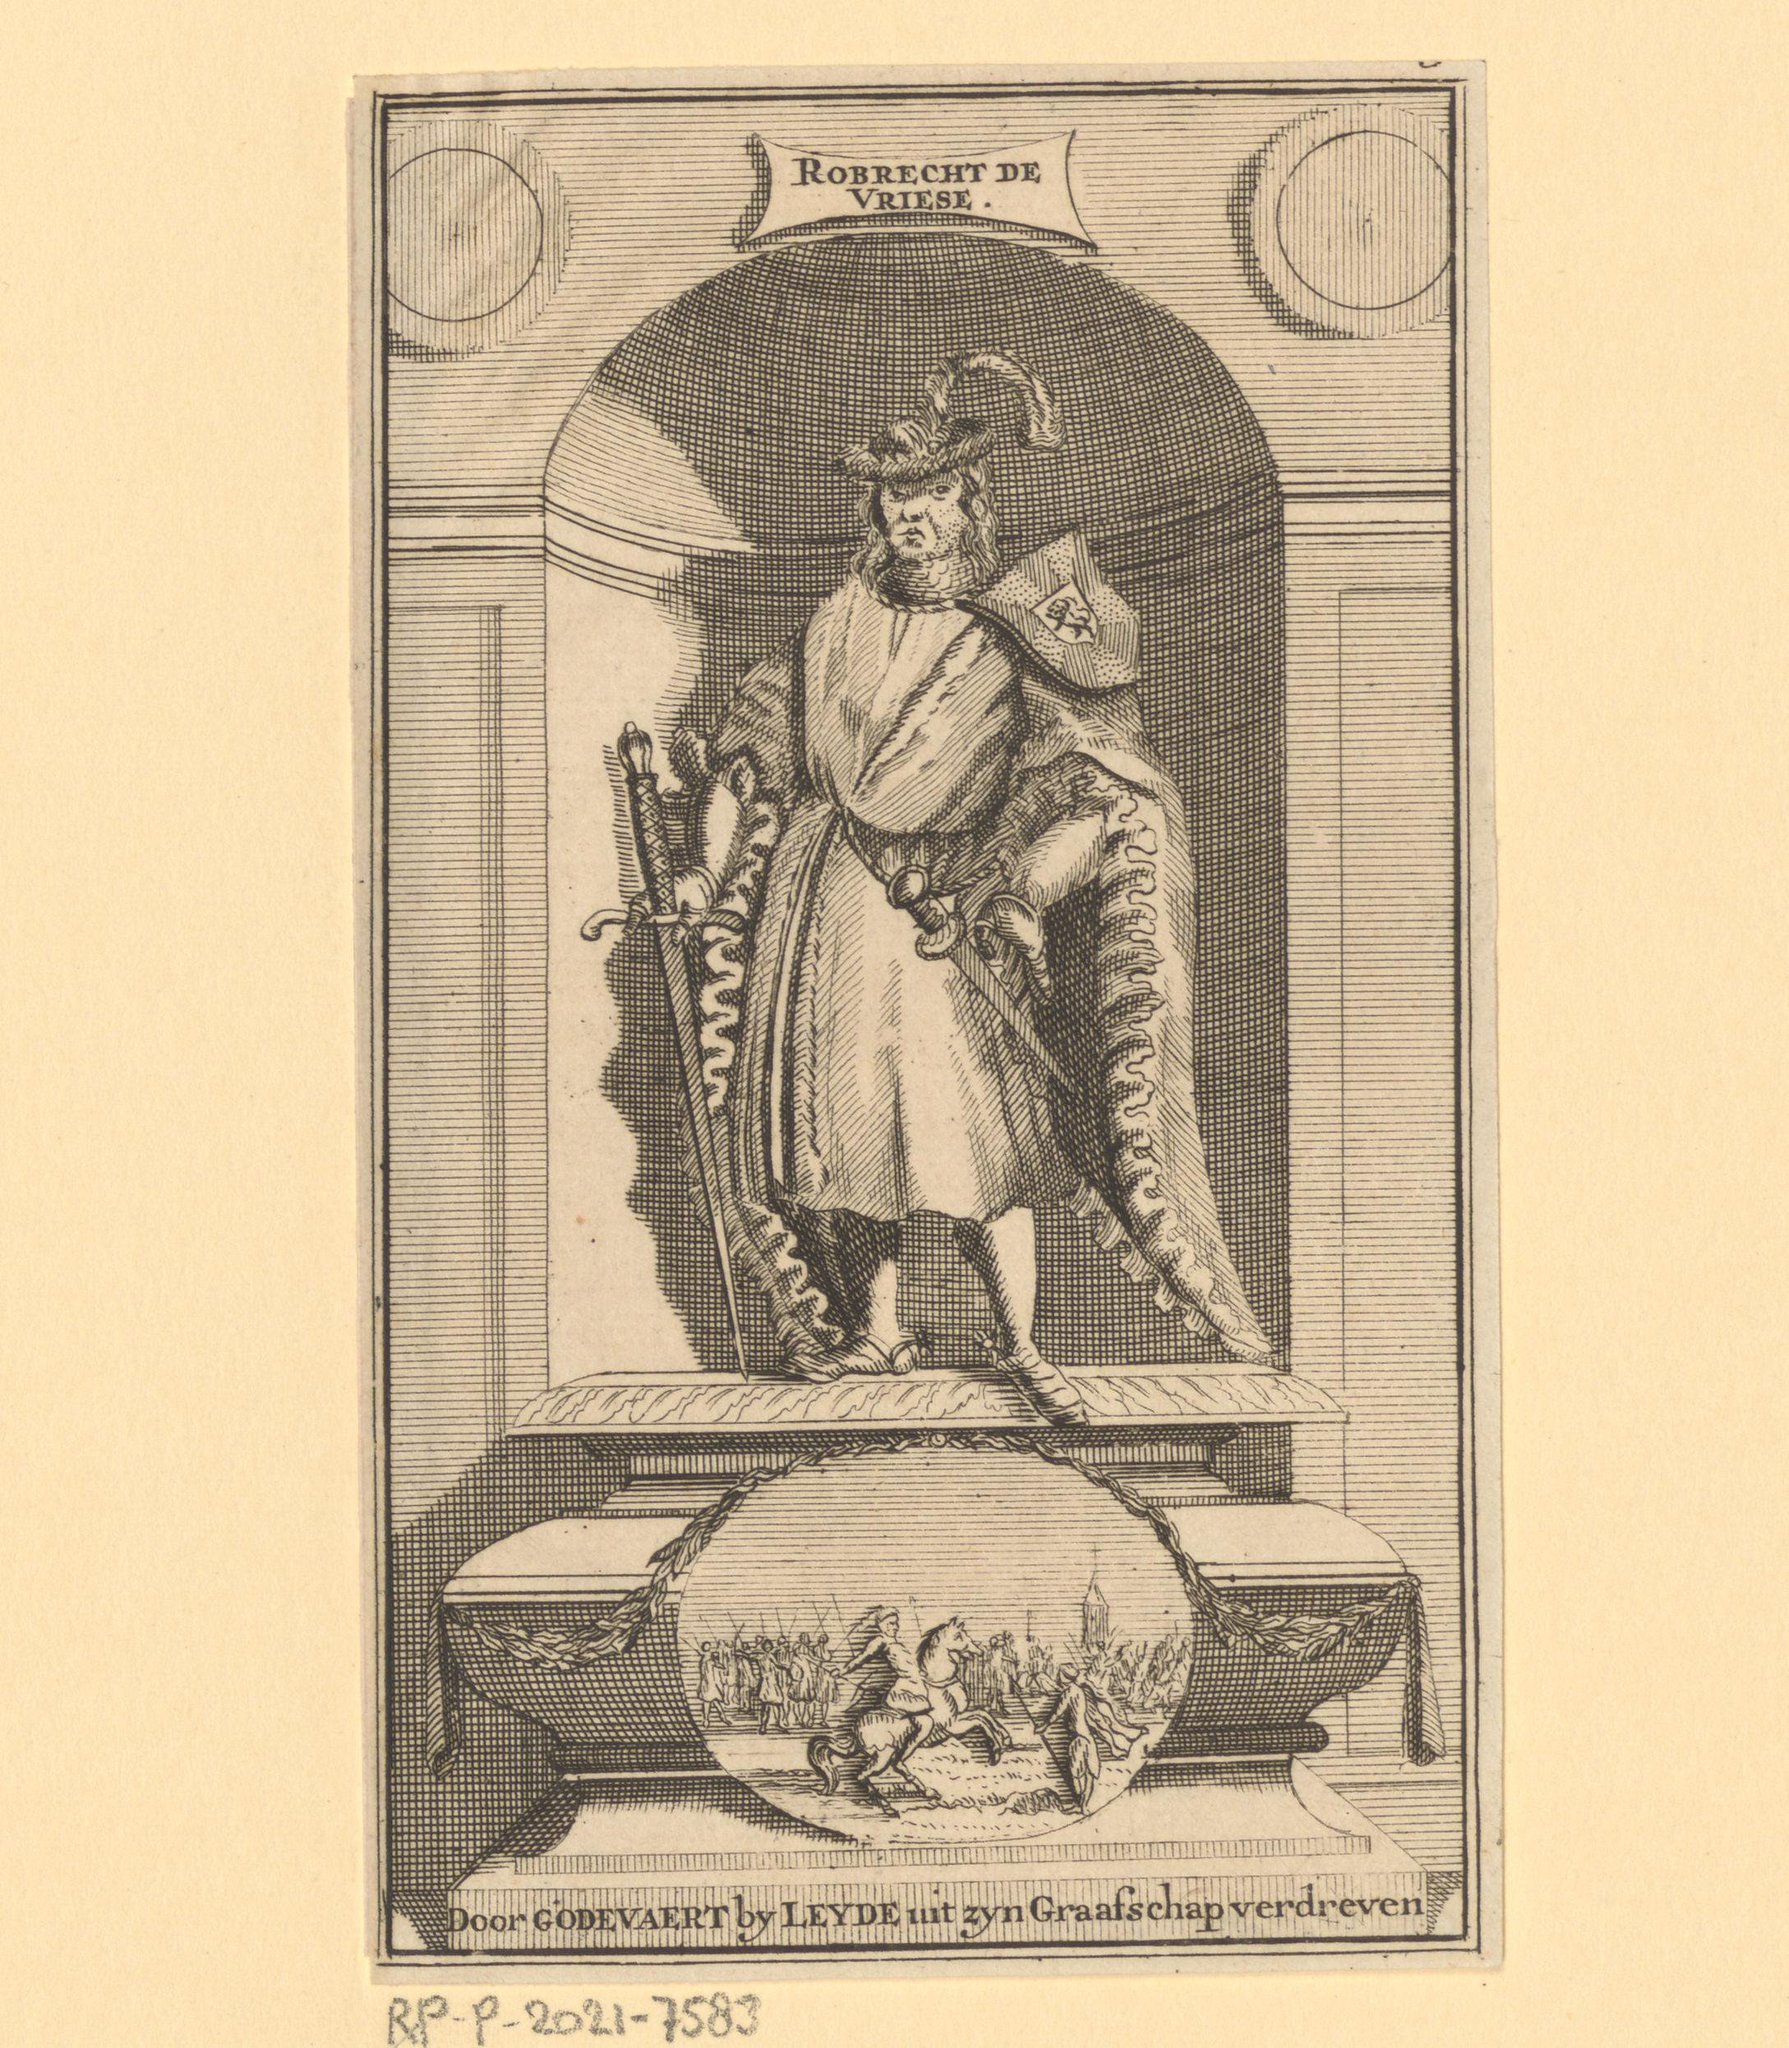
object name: print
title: Portret van Robrecht I de Fries, graaf van Vlaanderen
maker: Anonymous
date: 1702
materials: paper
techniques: etching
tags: historical persons, hacking and thrusting weapons: sword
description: Prent met tekst op verso gebruikt in: Soeteboom, Hendrik Jacobsz. Oud-heden van Zaan-land, Stavoren, Vronen en Waterland (...). 3 dln. Amsterdam: Wilhem Linnig van Koppenol, 1702, dl. 2.